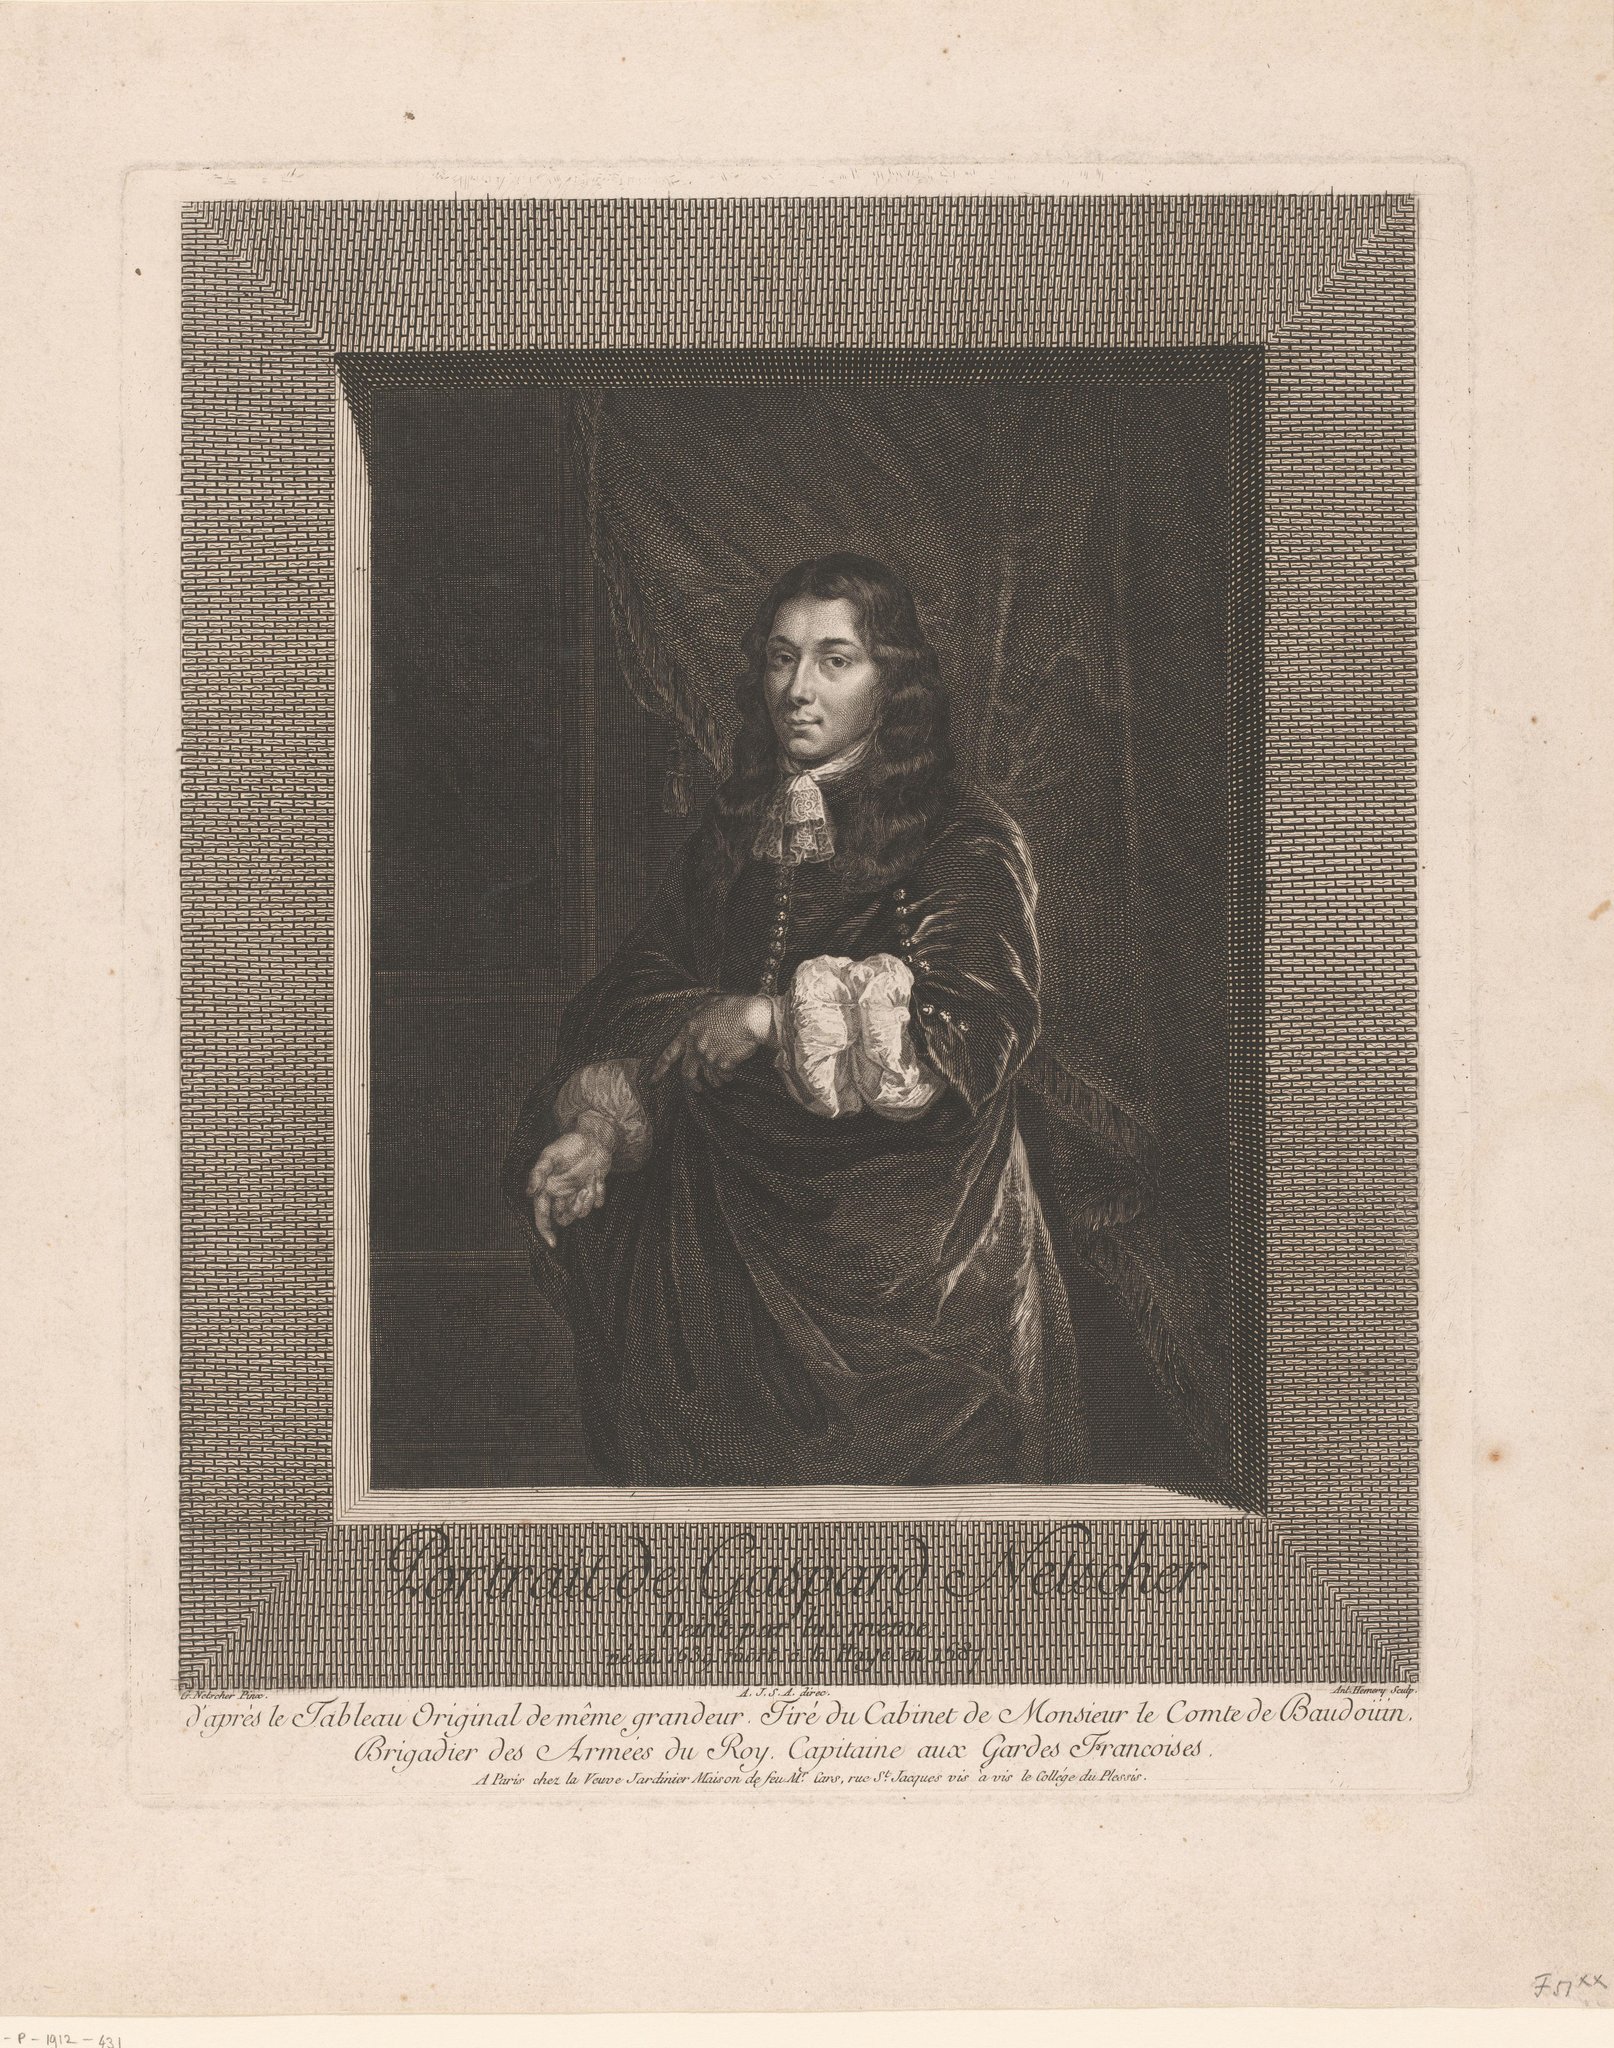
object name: print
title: Portret van Caspar Netscher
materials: paper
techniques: engraving, etching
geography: paris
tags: painter, print maker, draughtsman, caspar netscher, historical persons, portrait, self-portrait of artist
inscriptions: collector's mark: Lugt 2228